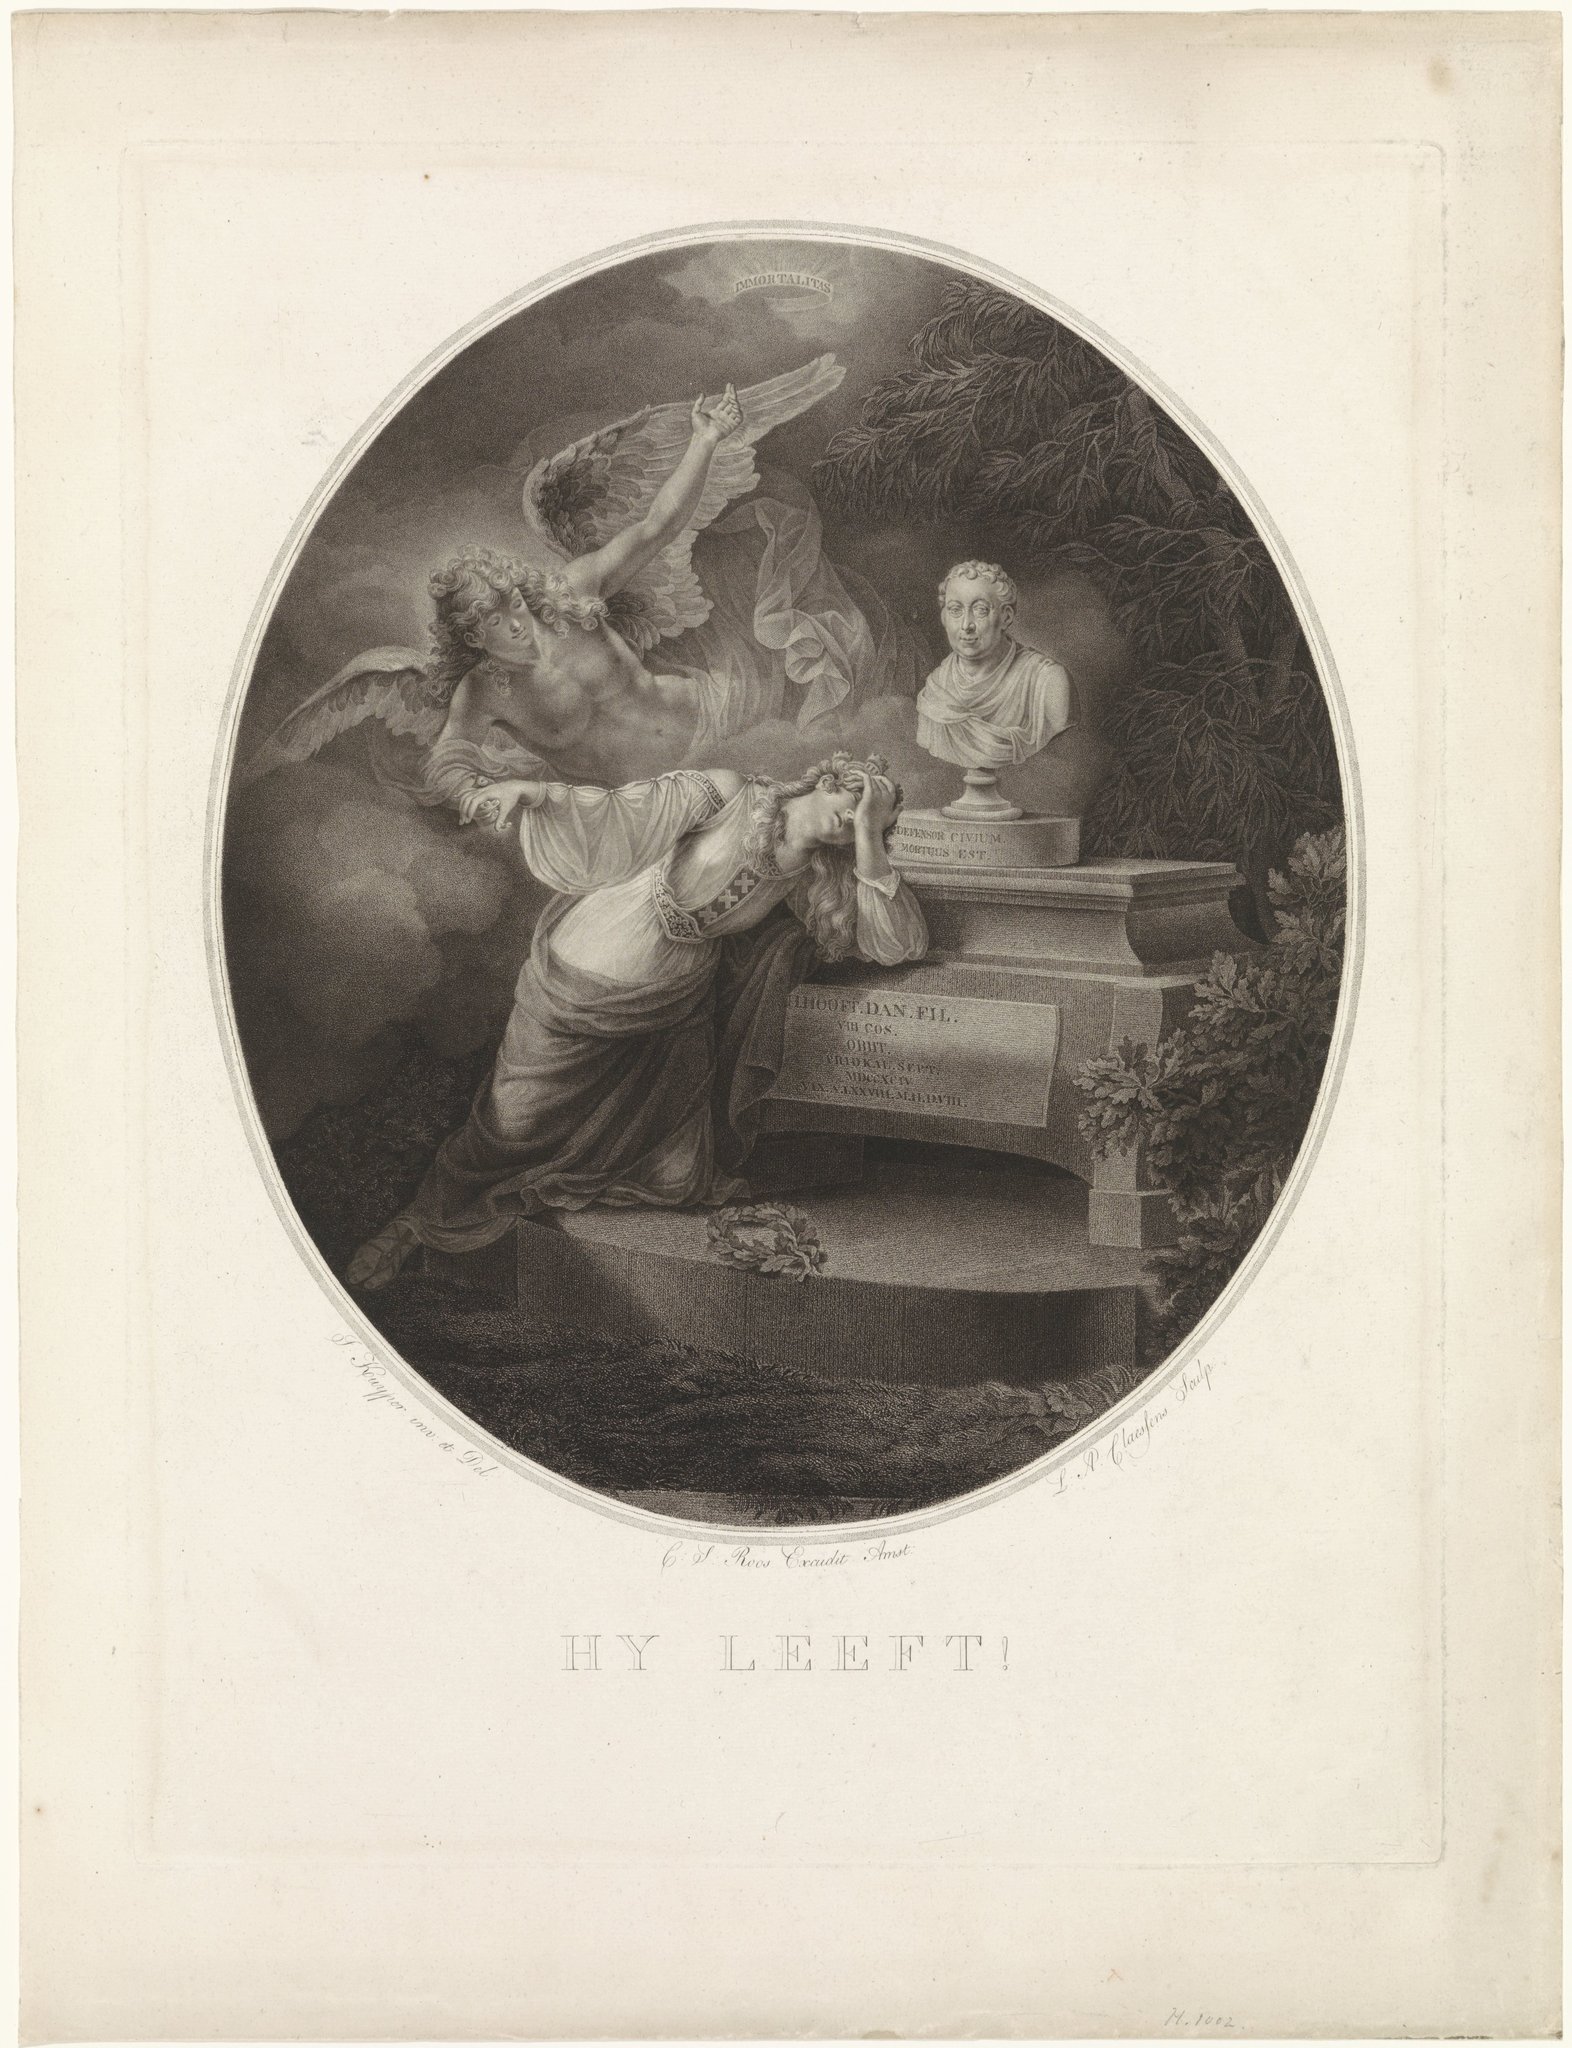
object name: print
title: Hy leeft!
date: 1794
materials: paper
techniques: engraving, etching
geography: amsterdam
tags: amsterdam, mayor, hendrik danielsz. hooft, grave-building, monumental tomb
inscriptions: collector's mark: Lugt 2228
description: De Amsterdamse stedenmaagd treurt aan het graf van Hendrik Hooft Daniëlsz. Op de stenen sarcofaag staat een portretbuste van de burgermeester. Een engel steunt de treurende maagd.